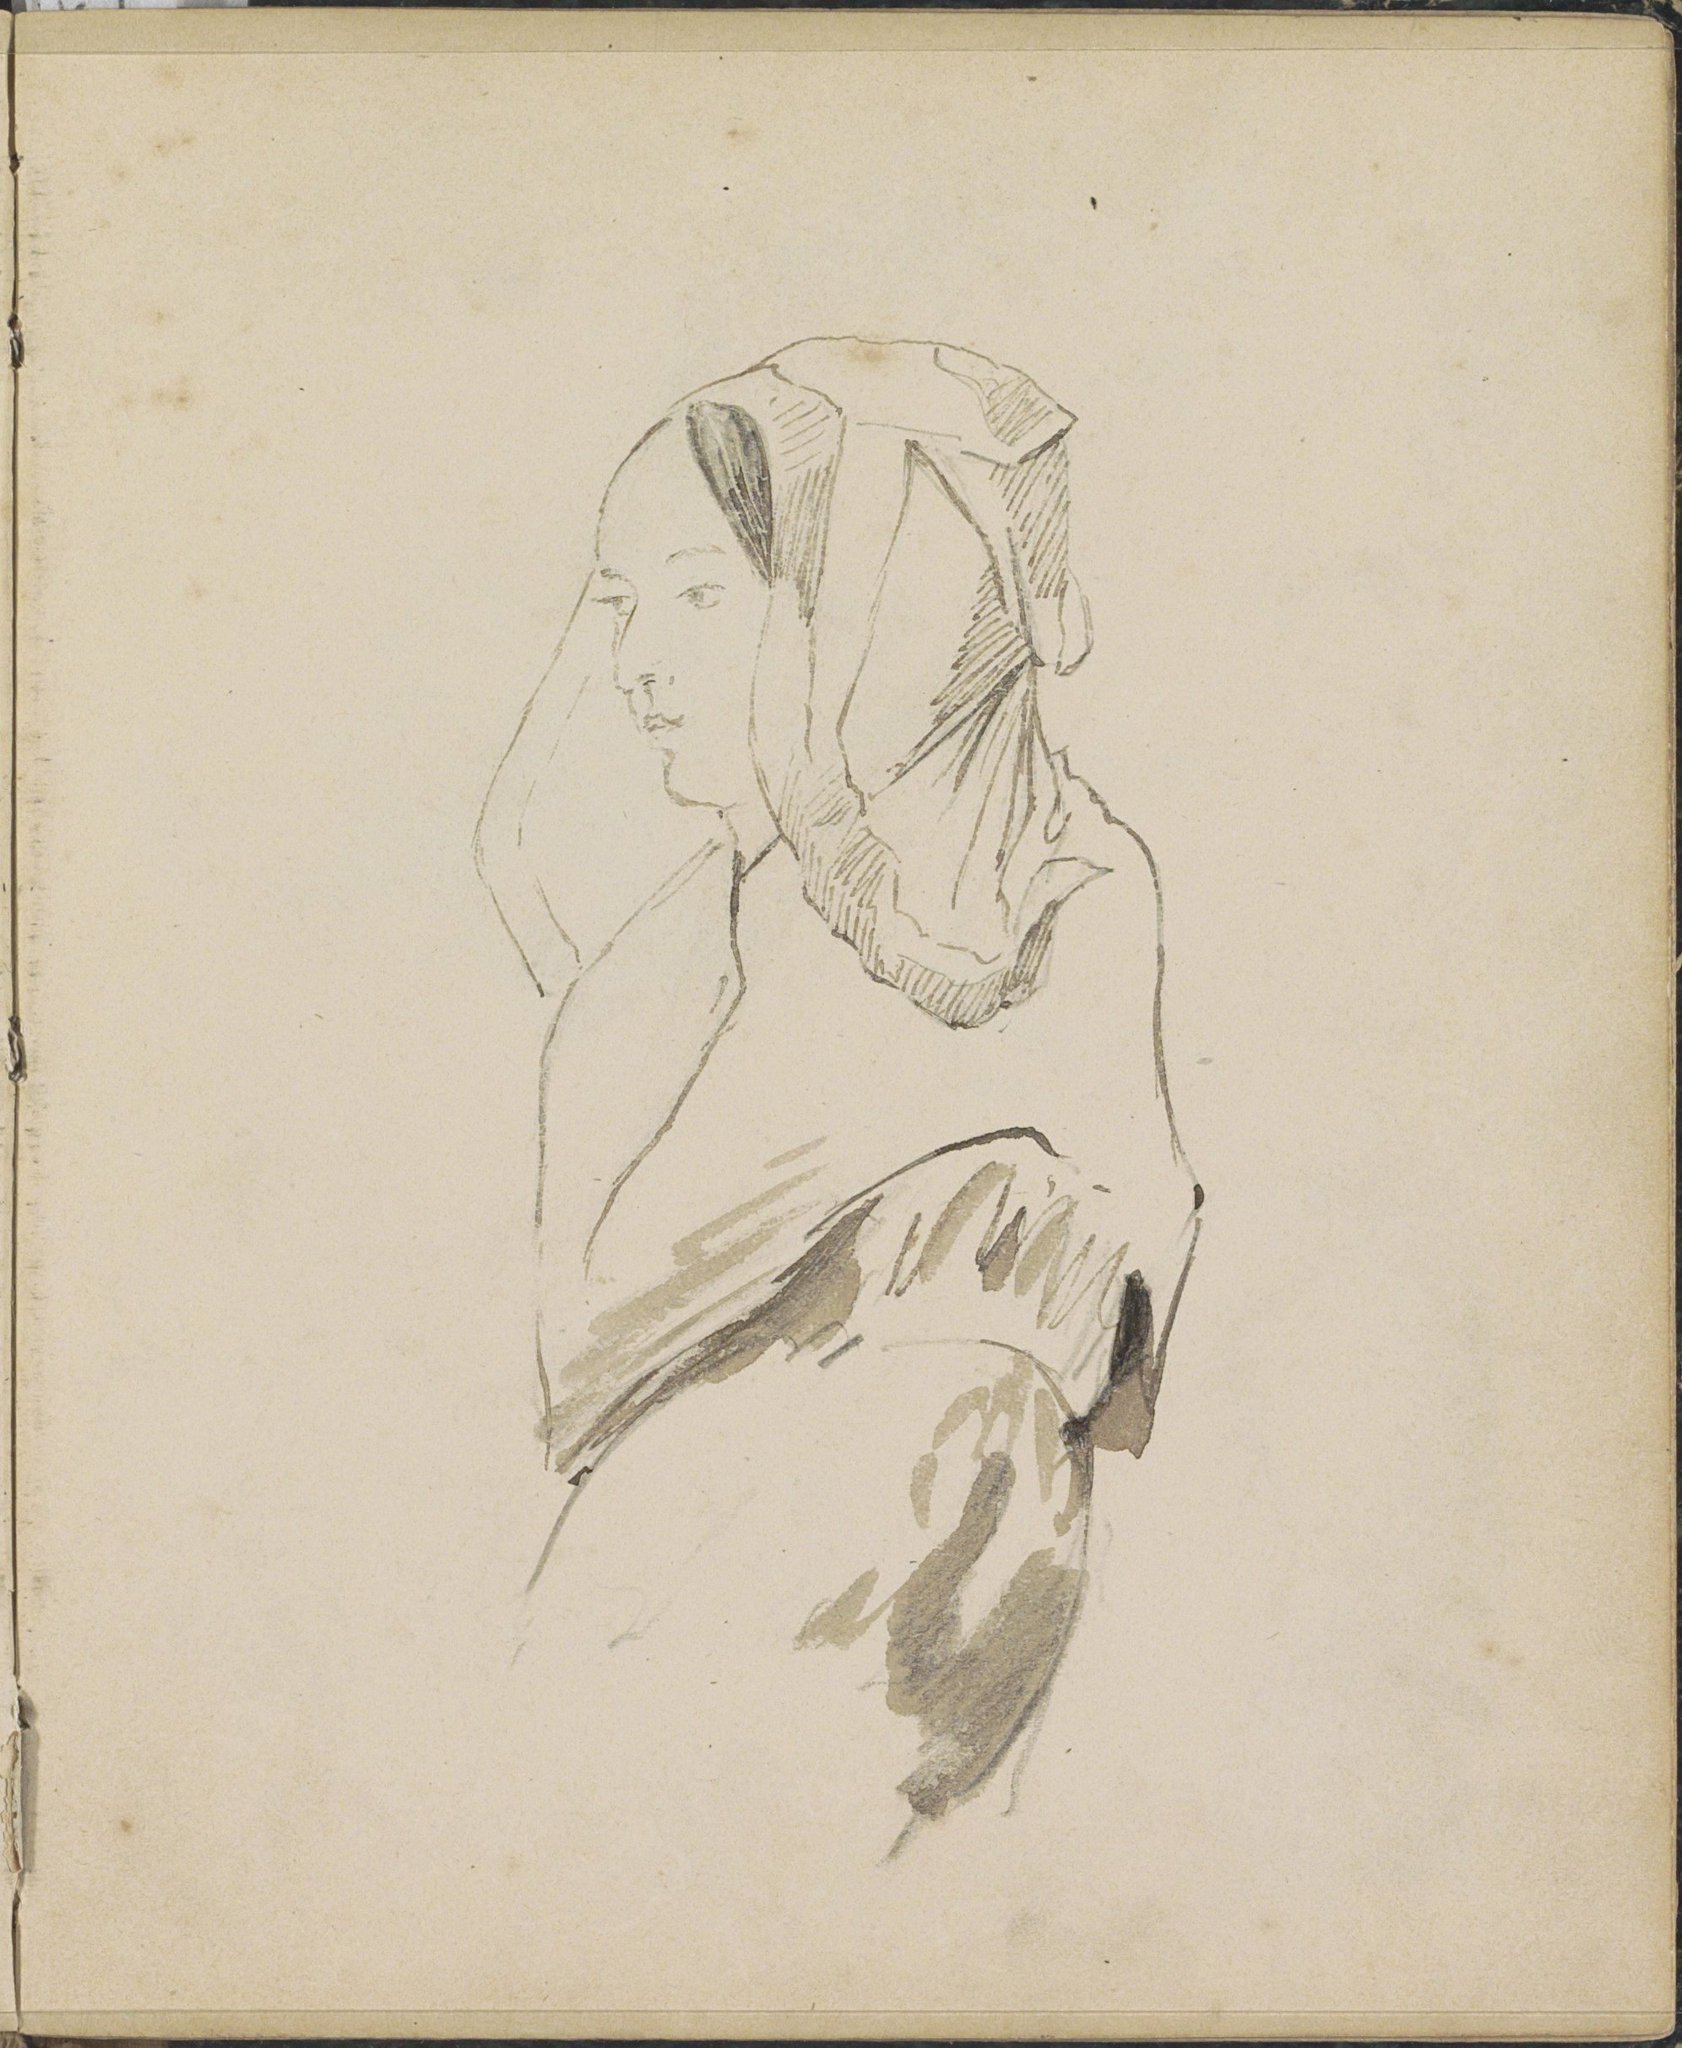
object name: sketchbook leaf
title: Vrouw met sluier, ten halven lijve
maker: johannes tavenraat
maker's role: draughtsman, painter, print maker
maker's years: 1809-1881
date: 1841-1853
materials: ink, paper, pencil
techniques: brush, pen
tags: adult woman, veil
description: Blad 36 recto uit een schetsboek met 87 bladen.